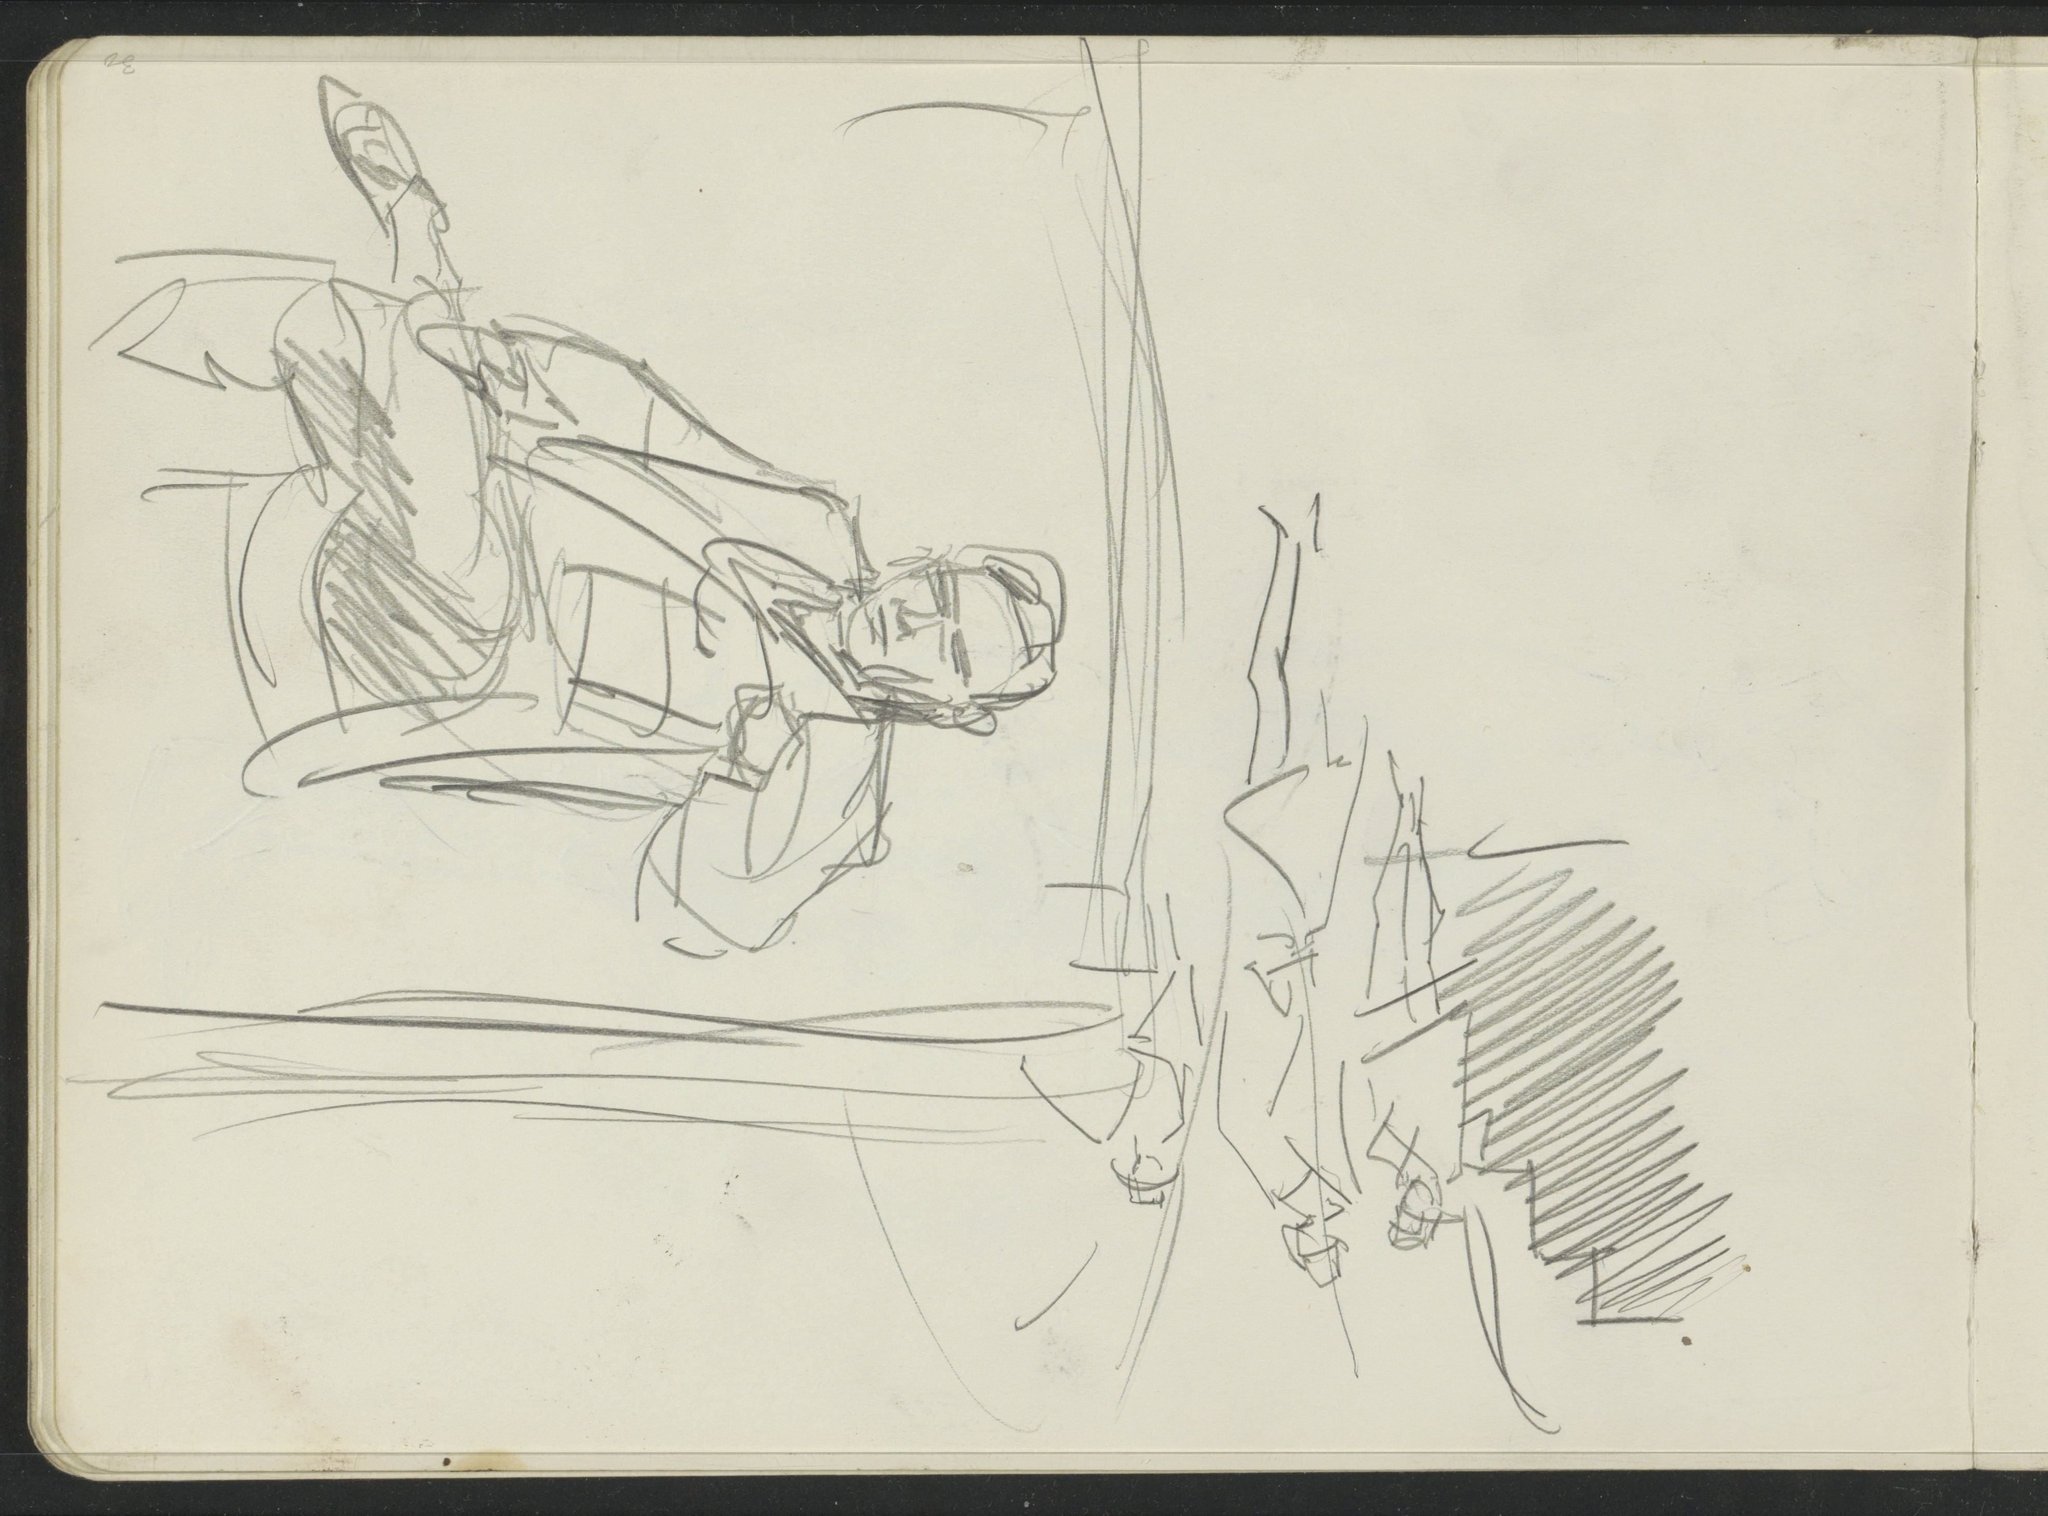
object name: sketchbook leaf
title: Man op een stoel en staande vrouwen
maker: isaac israels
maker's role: draughtsman, painter, print maker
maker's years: 1865-1934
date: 1915-1934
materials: paper, pencil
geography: the hague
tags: adult man (+ sitting), standing figure - aa - female human figure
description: De linkerarm van de man rust op de leuning. Zijn linkerbeen ligt op zijn rechterbeen. Blad 15 verso uit schetsboek XV met 22 bladen.